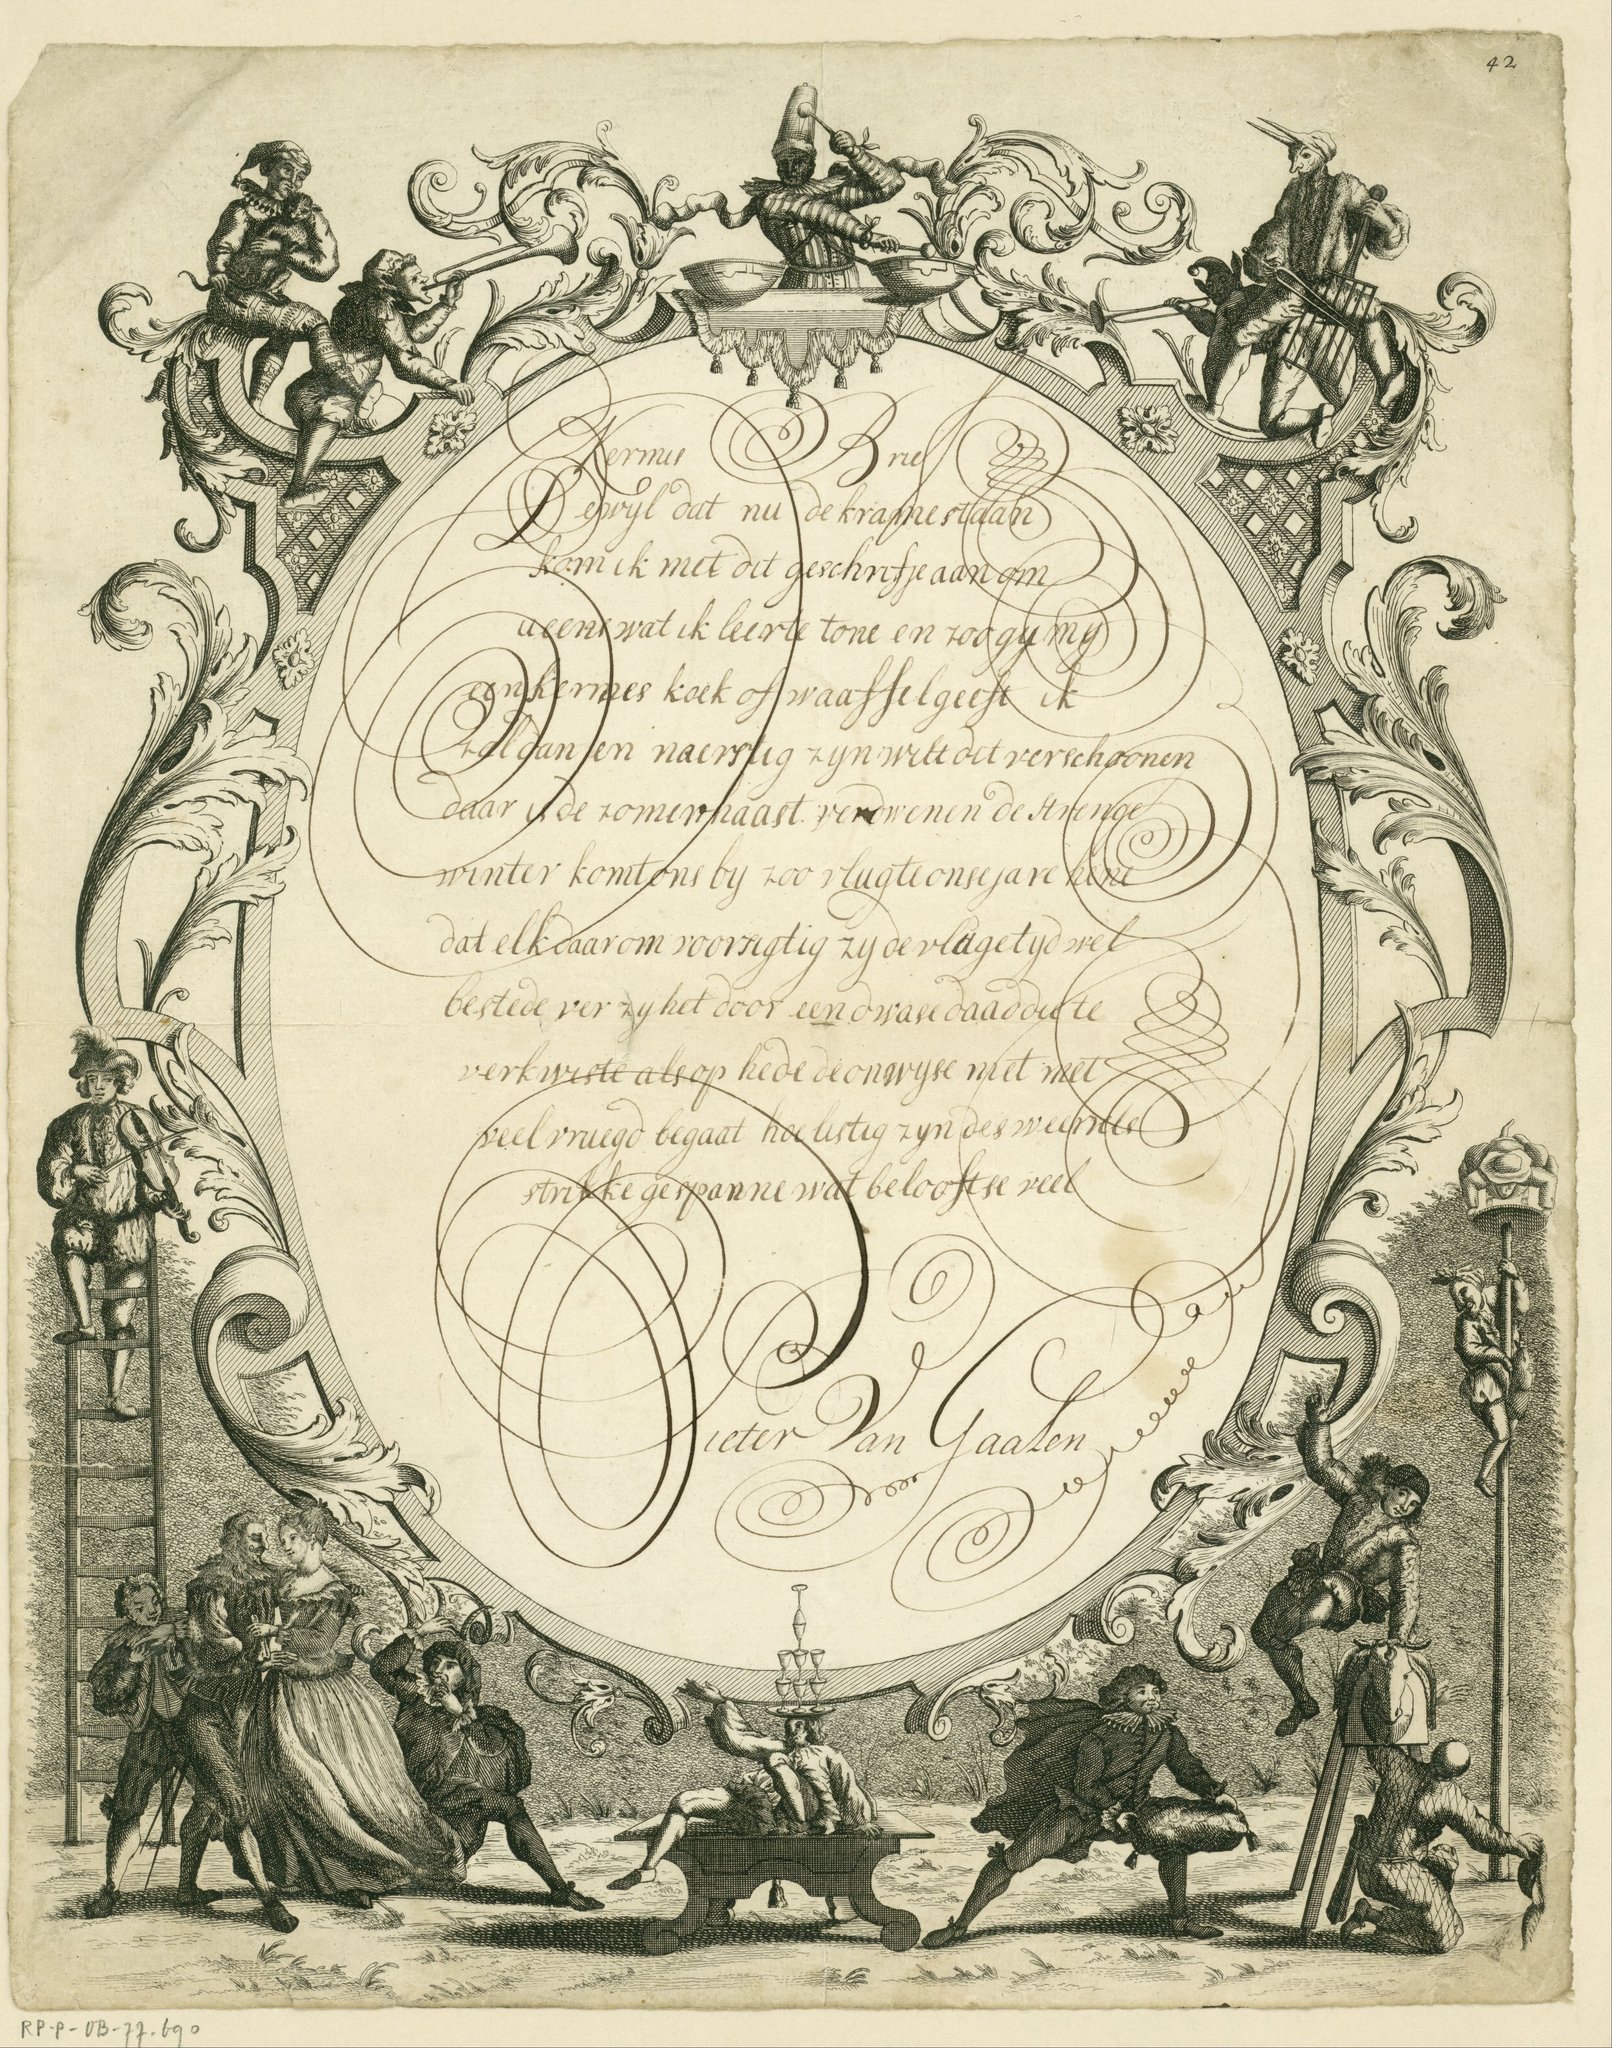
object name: print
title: Wensbrief met acrobaten, muzikanten en een dansend paar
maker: Anonymous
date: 1700-1899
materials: ink, paper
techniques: calligraphy, etching, pen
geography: netherlands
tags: the show; fair and circus performers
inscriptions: inscription: ‘Kermis brief / Terwijl dat nu de krame staan ...’, collector's mark: Lugt 2760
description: Wensbrief met beschreven cartouche binnen een decoratief kader met voorstellingen van circusartiesten en een dansend paar. Handgeschreven bericht in kalligrafie (kermisbrief) door Pieter van Gaalen. Genummerd rechtsboven: 42.